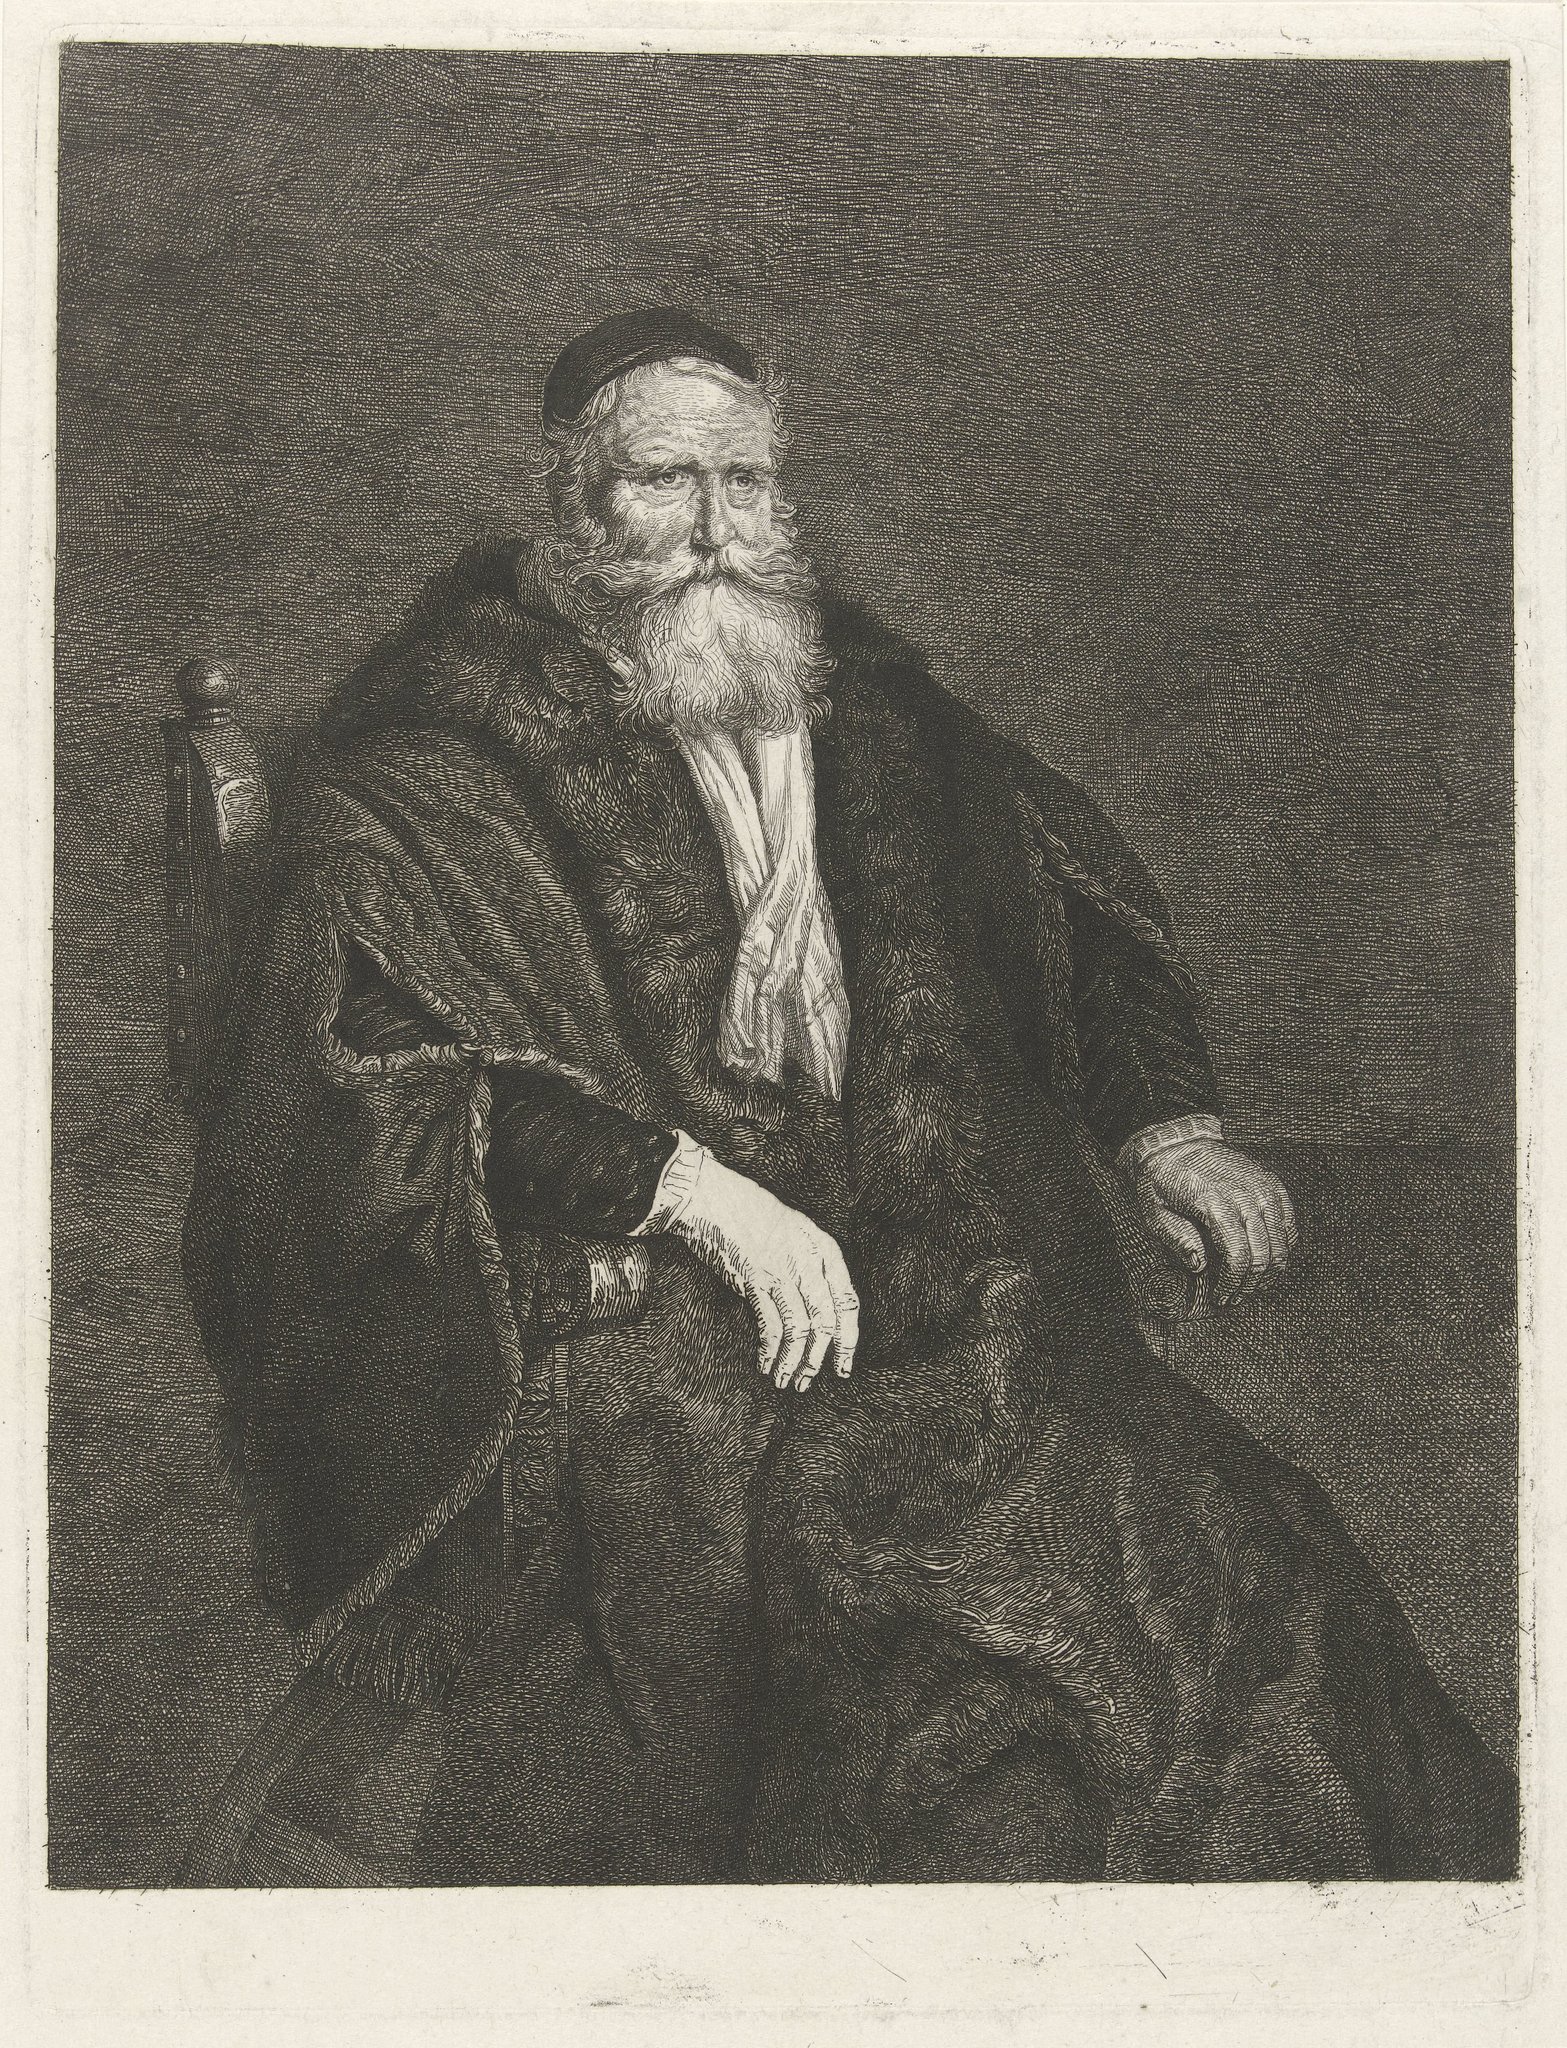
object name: print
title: Portret van een onbekende oude man in een leunstoel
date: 1801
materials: paper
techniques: etching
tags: sitting figure, old man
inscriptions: collector's mark: Lugt 2228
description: Portret van een onbekende oude man in een leunstoel. Kniestuk, zittend naar rechts gedraaid. Zijn armen rusten op de stoelleuningen. De man is gehuld in een met bont omzoomde mantel en draagt een hoofddeksel.